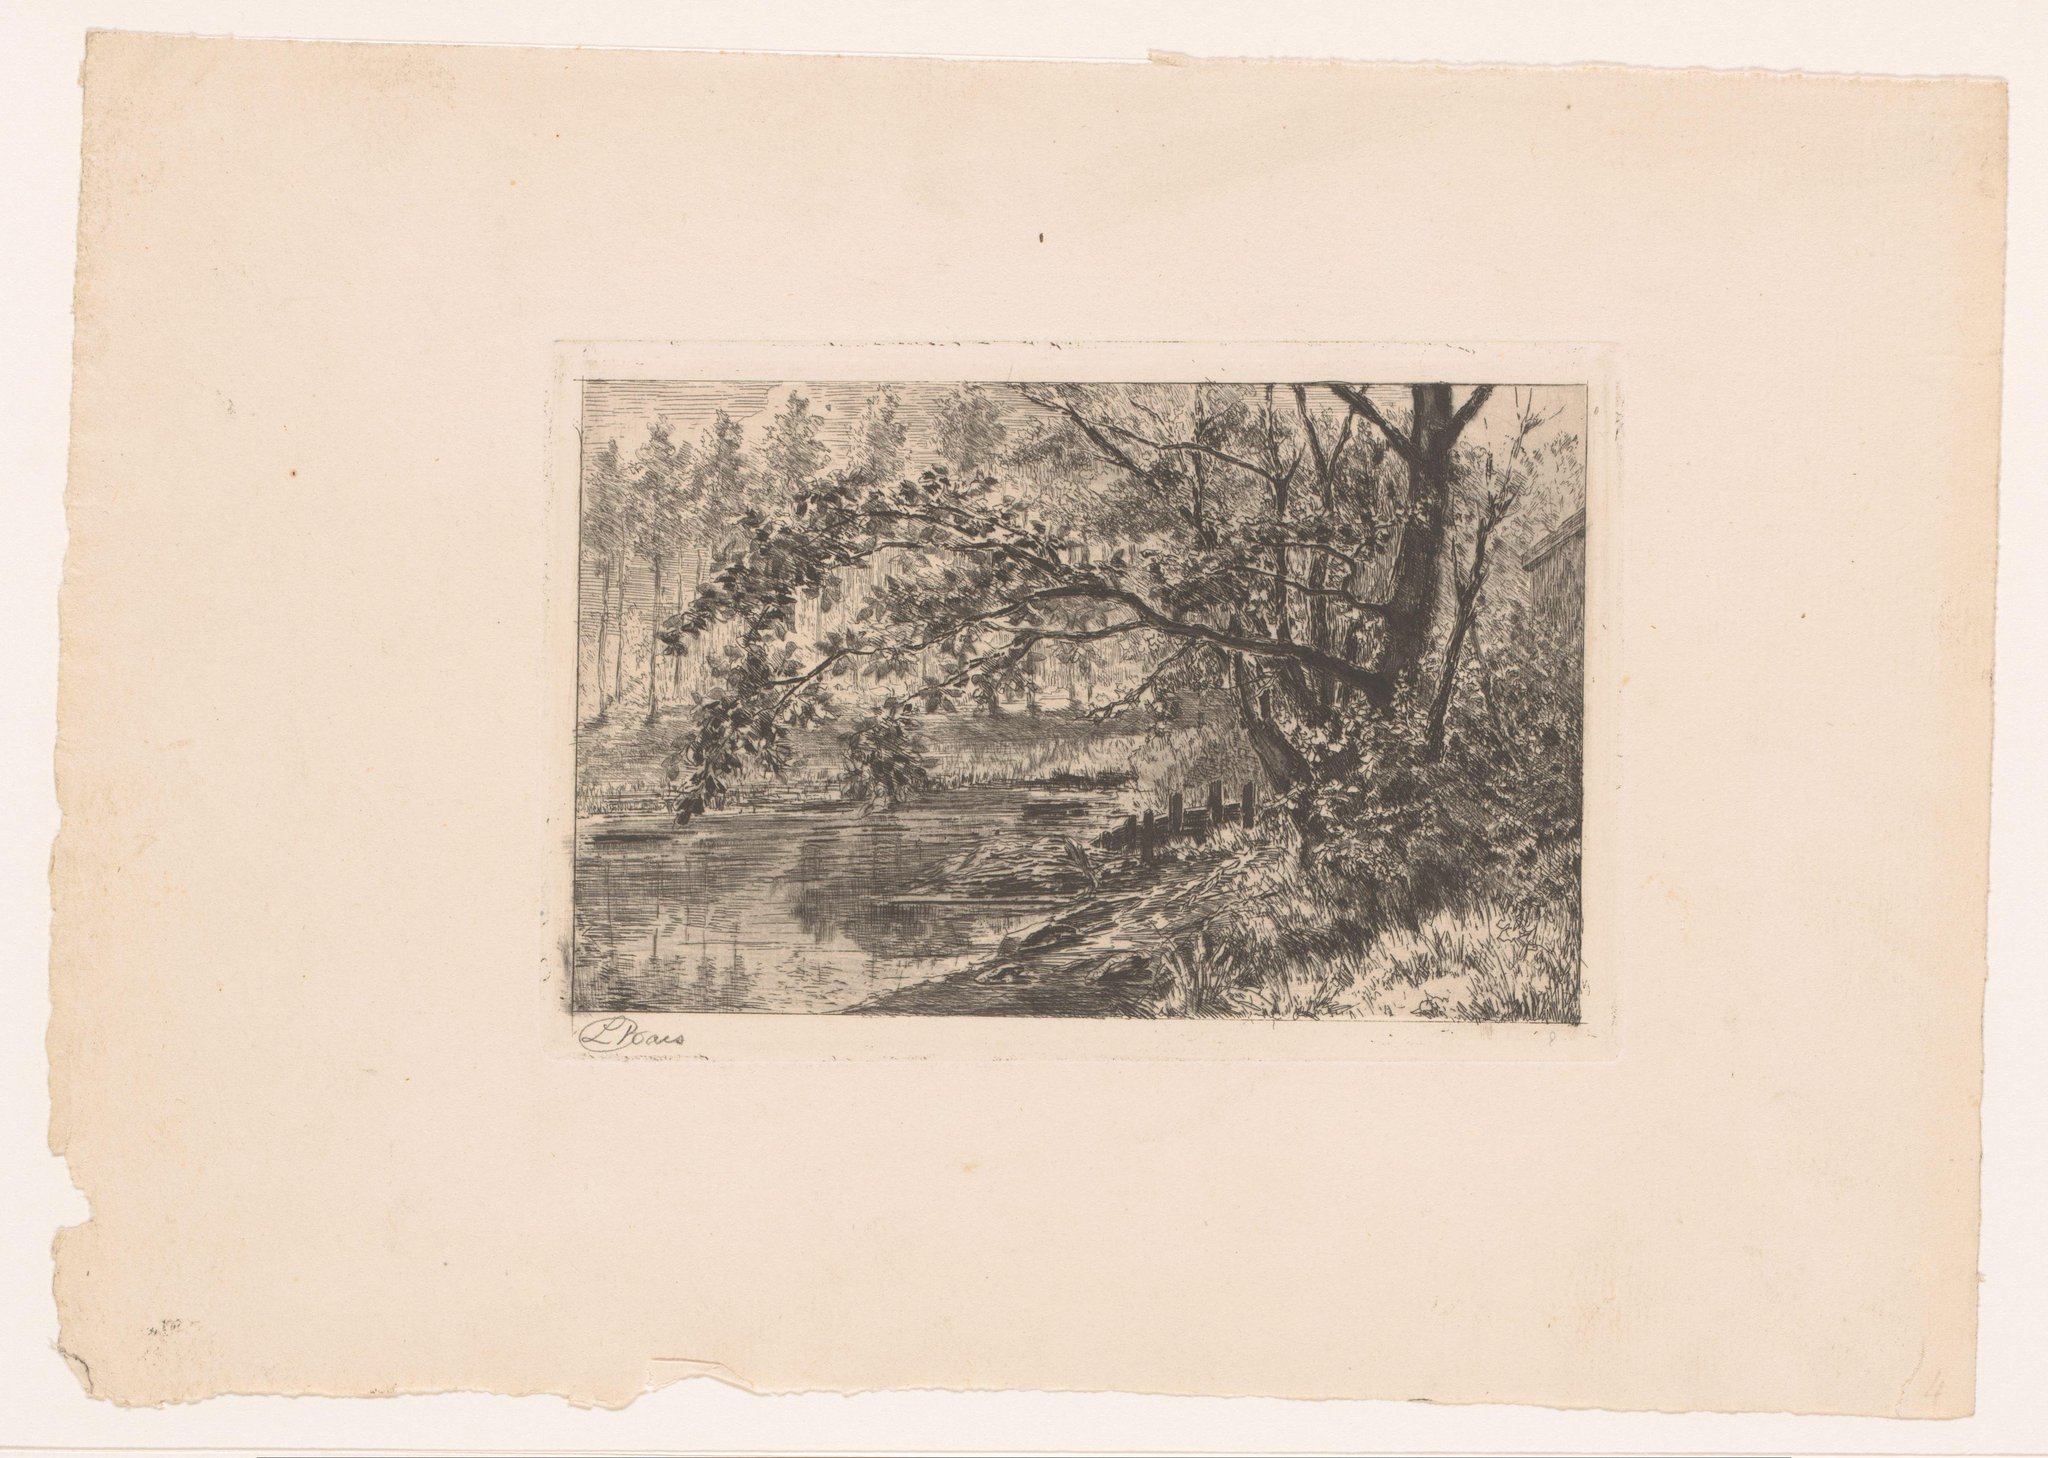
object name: print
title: Vijver van Groenendaal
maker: lionel oscar baes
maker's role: print maker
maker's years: 1839-1913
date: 1876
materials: paper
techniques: drypoint, etching, intaglio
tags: forest, wood, pond, pool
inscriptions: collector's mark: Lugt 2228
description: Prent uit: Album du Journal des Beaux-Arts. Antwerpen: s.n., 1876.